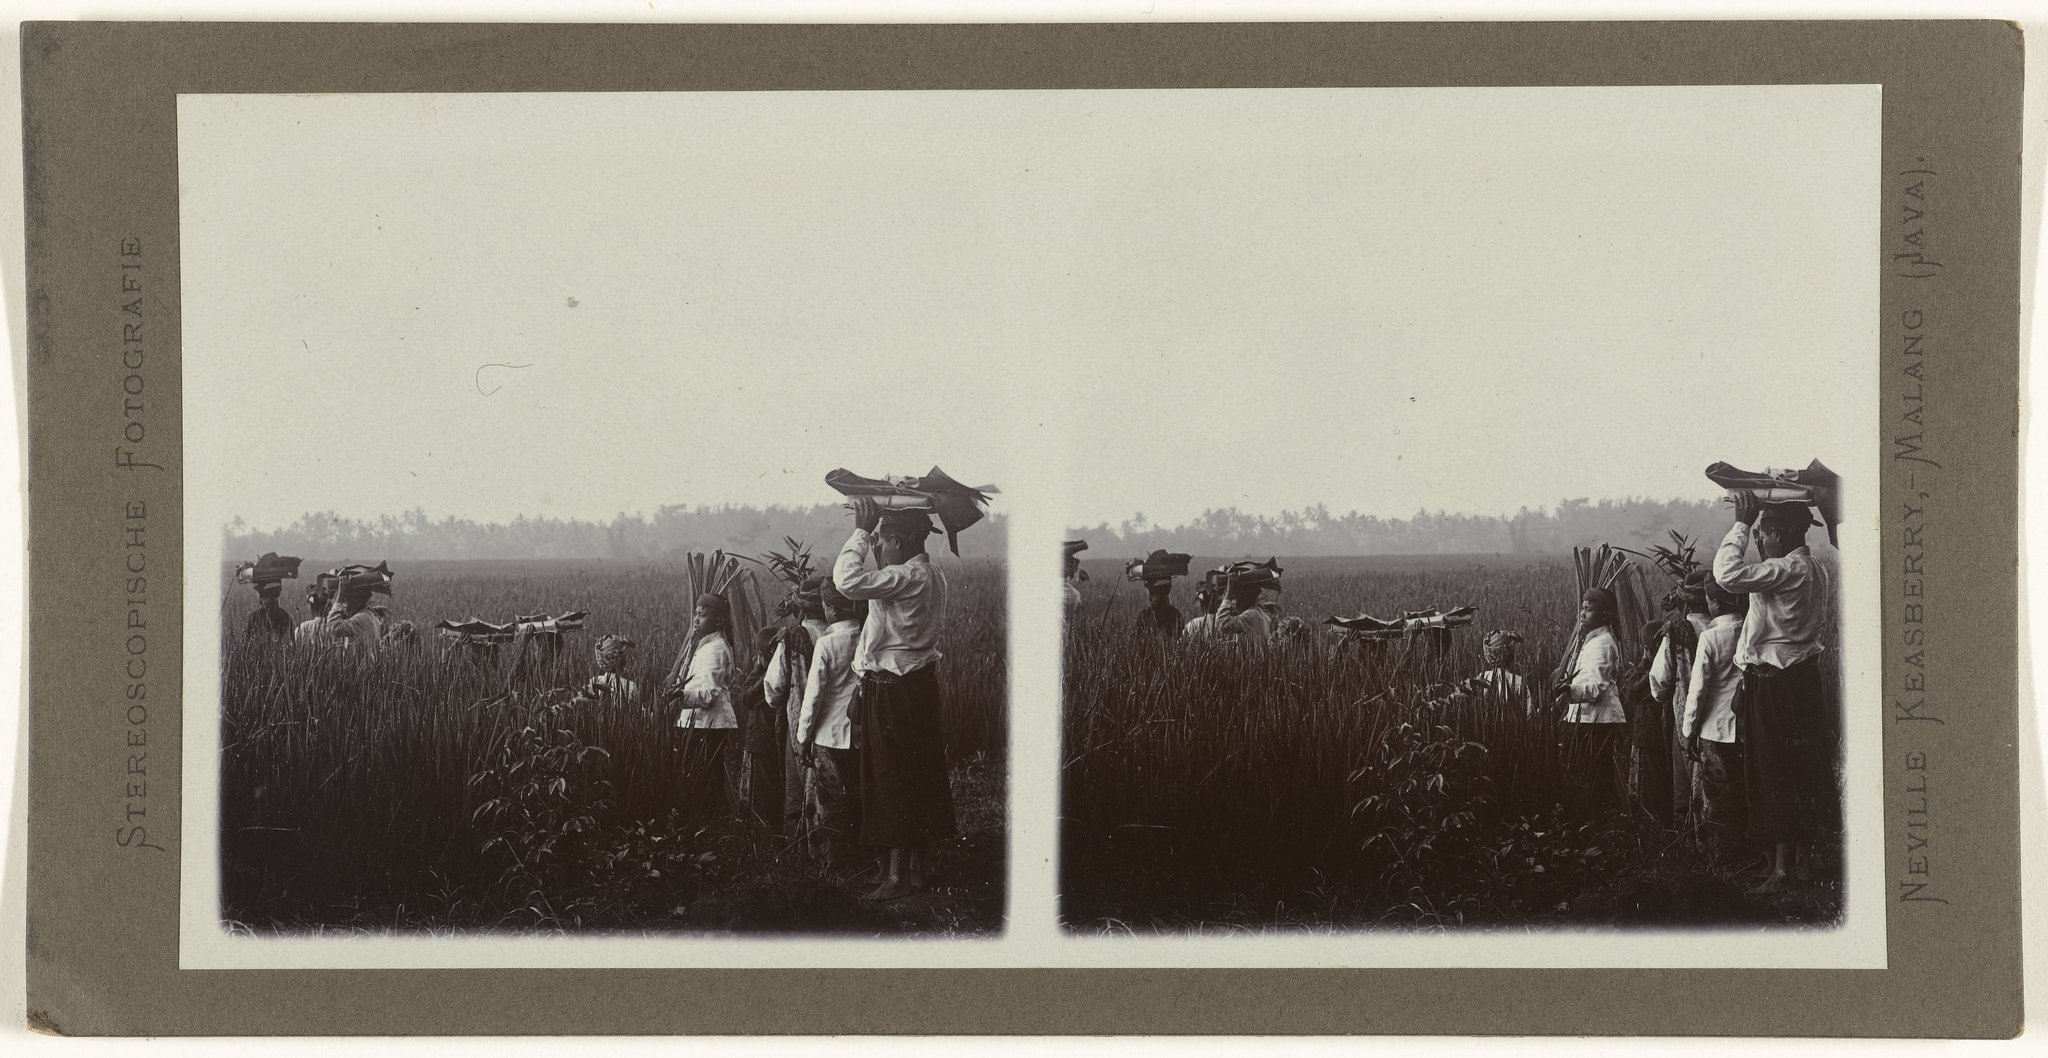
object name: stereograph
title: Rijstcultuur, Slametan voor 't staande gewas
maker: neville keasberry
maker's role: fotograaf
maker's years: 1866-1944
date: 1900-1935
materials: cardboard, paper, photographic support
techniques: albumen print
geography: malang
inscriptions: annotation: ‘S 5 no 54. Rijstcultuur. Slametan voor 't staande gewas’, signature: ‘Neville Keasberry, Malang (Java)’, inscription: ‘Stereoscopische Fotografie’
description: Een slametan is een terug kerend gemeenschapsfeest waarbij de eenheid van de betrokkenen gevierd wordt. Deze worden bij diverse sociale gebeurtenissen gegeven, oogsten, verjaardagen, begrafenissen, etc. [M. Knops, 2008].